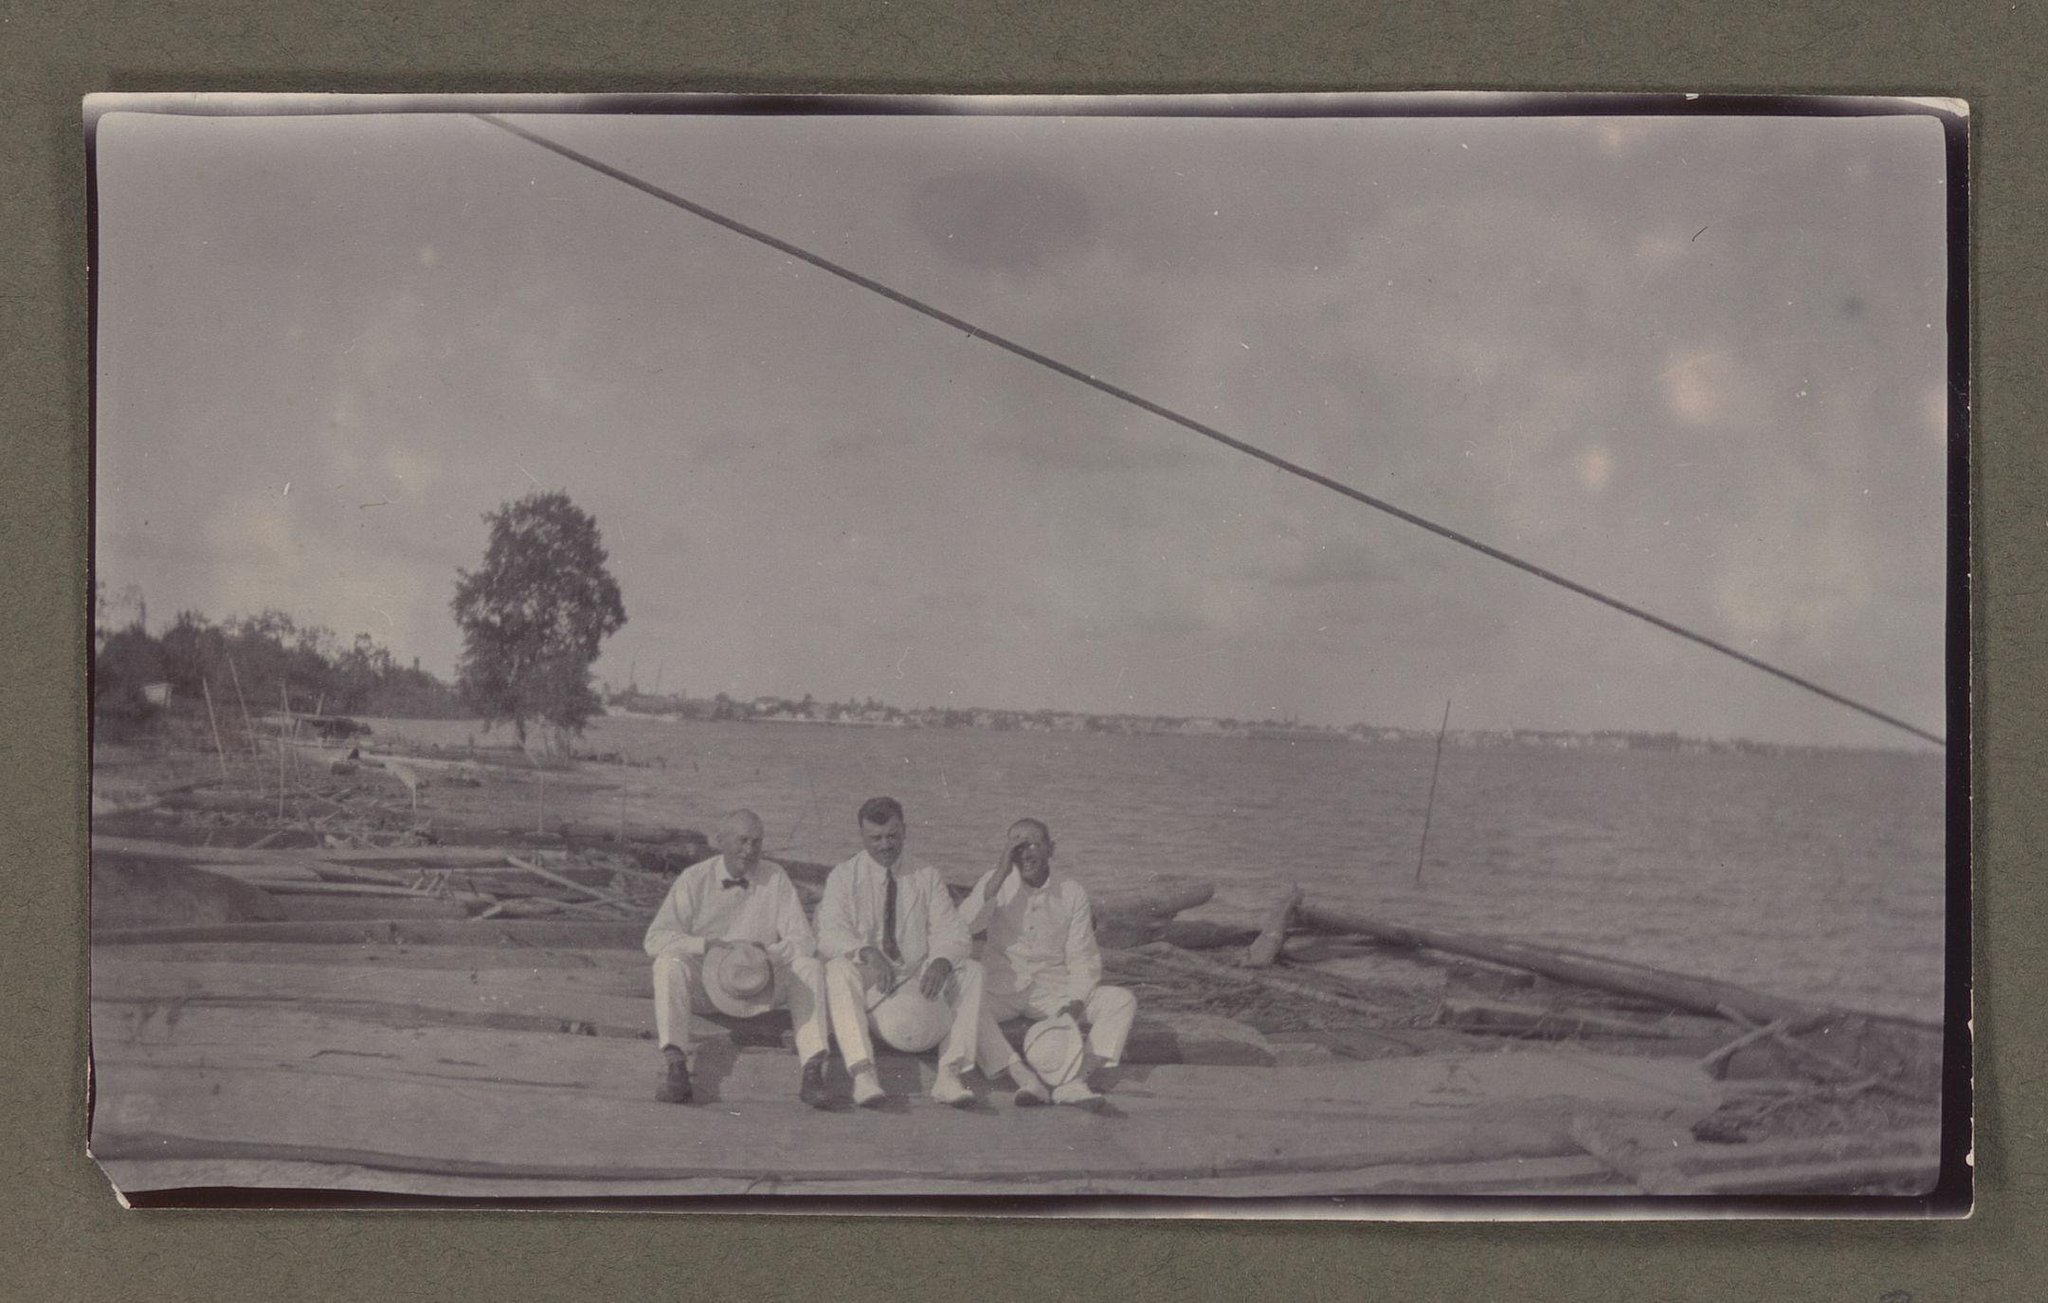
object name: photograph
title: Aan de Waterkant van Paramaribo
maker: Anonymous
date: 1925-1927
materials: photographic support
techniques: photography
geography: suriname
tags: jetten, familie, moengo, waterkant, paramaribo (stad)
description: Drie mannen (waaronder R.A. Jetten) aan de Waterkant van Paramaribo. Foto op een bladzijde van een los albumblad. Onderdeel van het ensemble met foto's van de familie van ingenieur Jetten in de mijnbouwstad Moengo in Suriname.